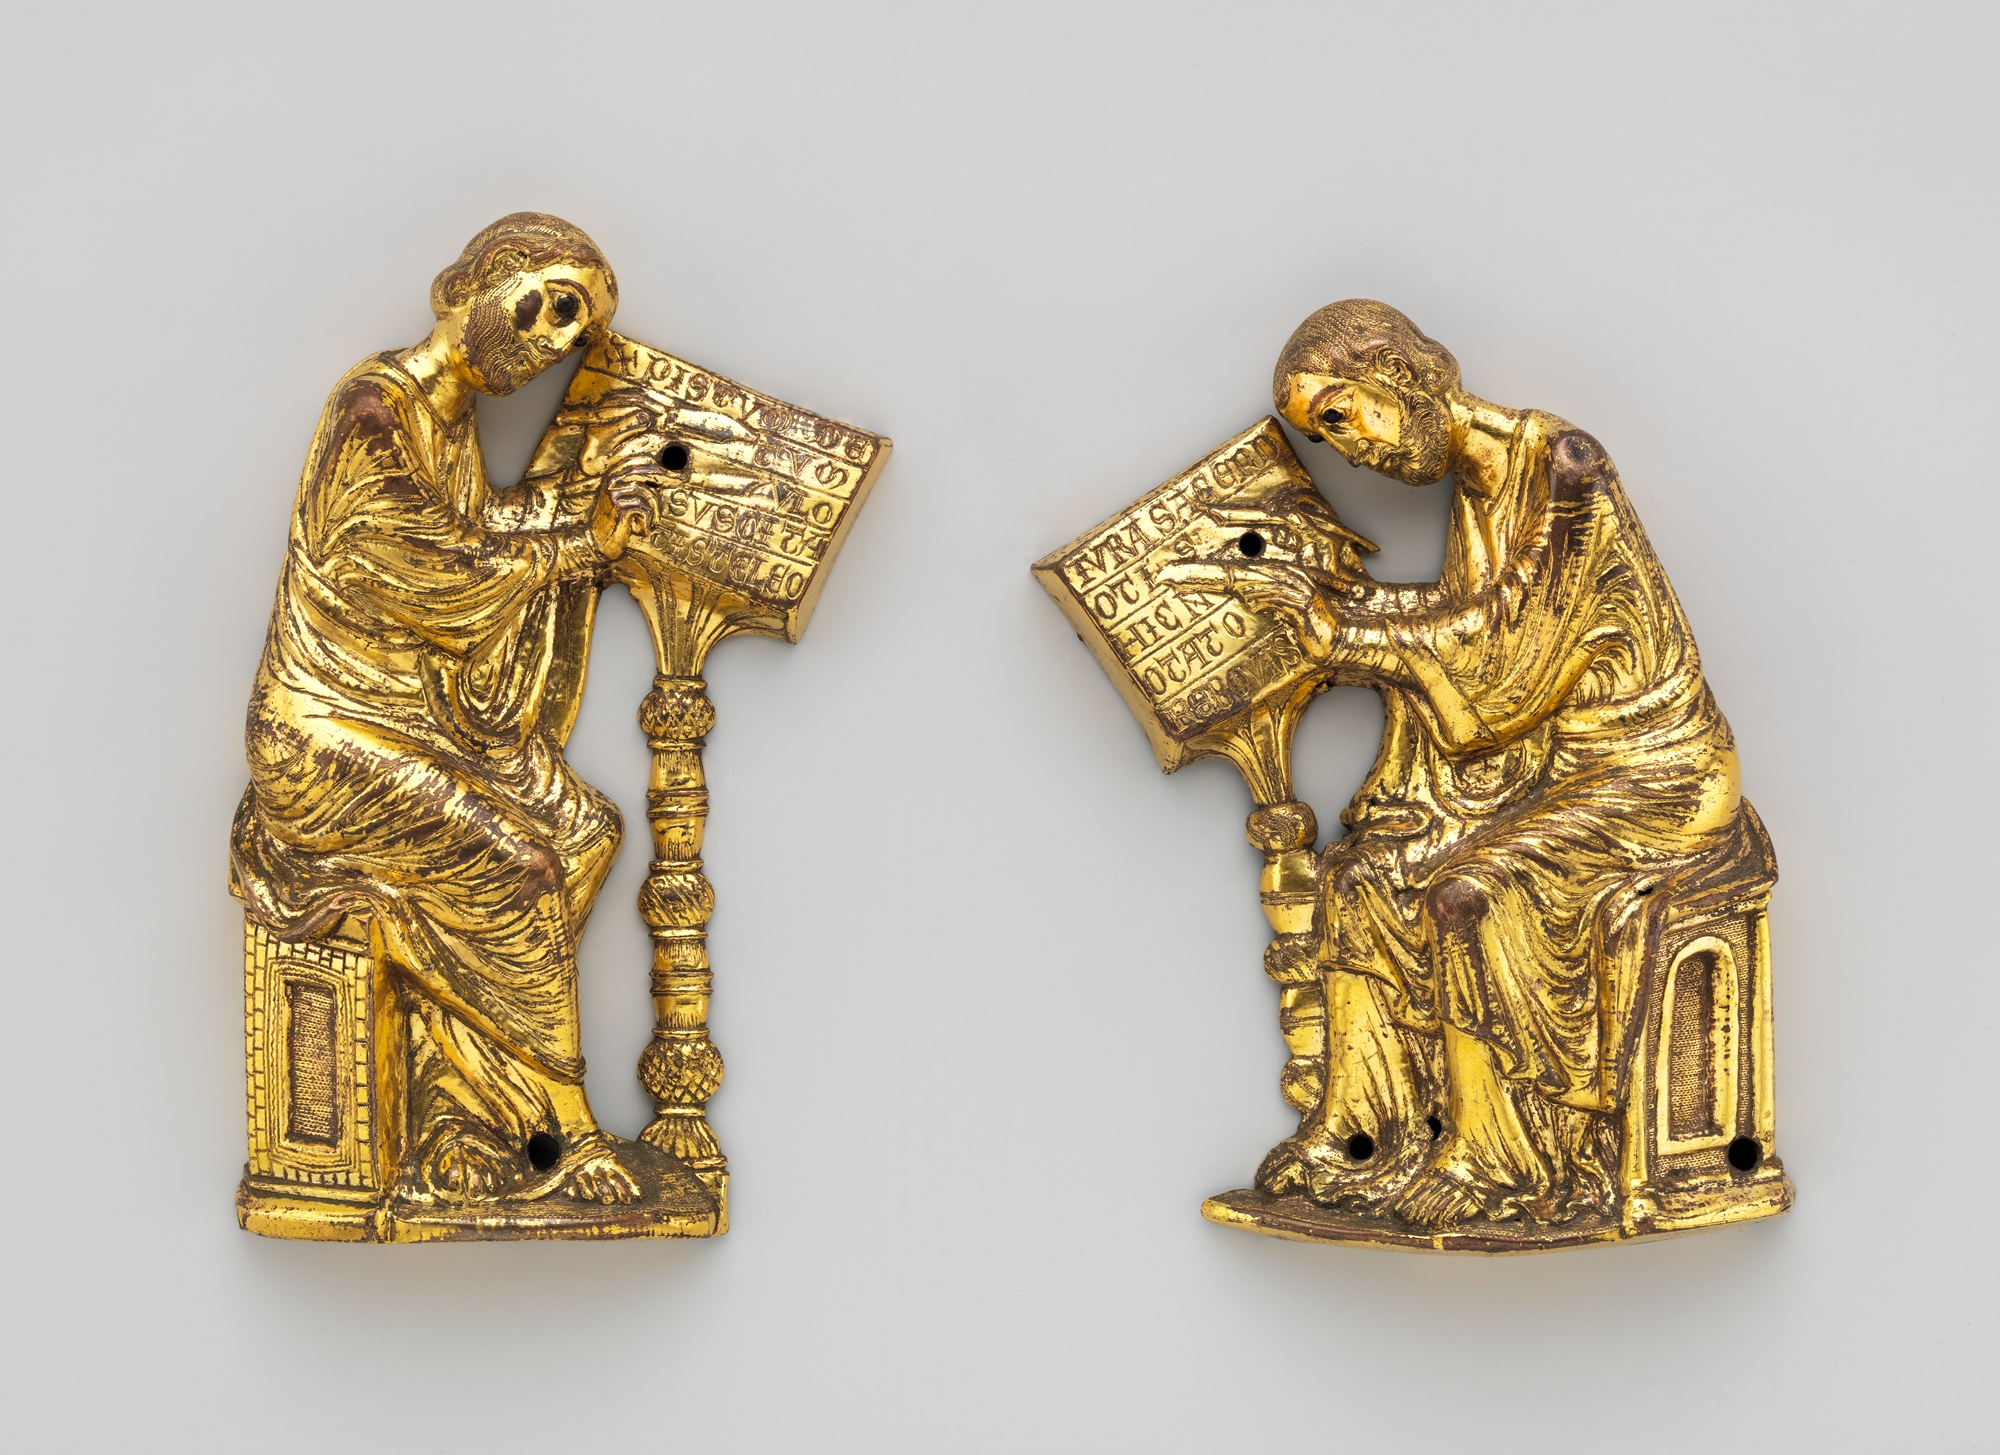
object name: plaque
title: Evangelists Mark and Luke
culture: french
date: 1220-1230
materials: gilt copper, glass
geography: france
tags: saint mark,writing,saint luke